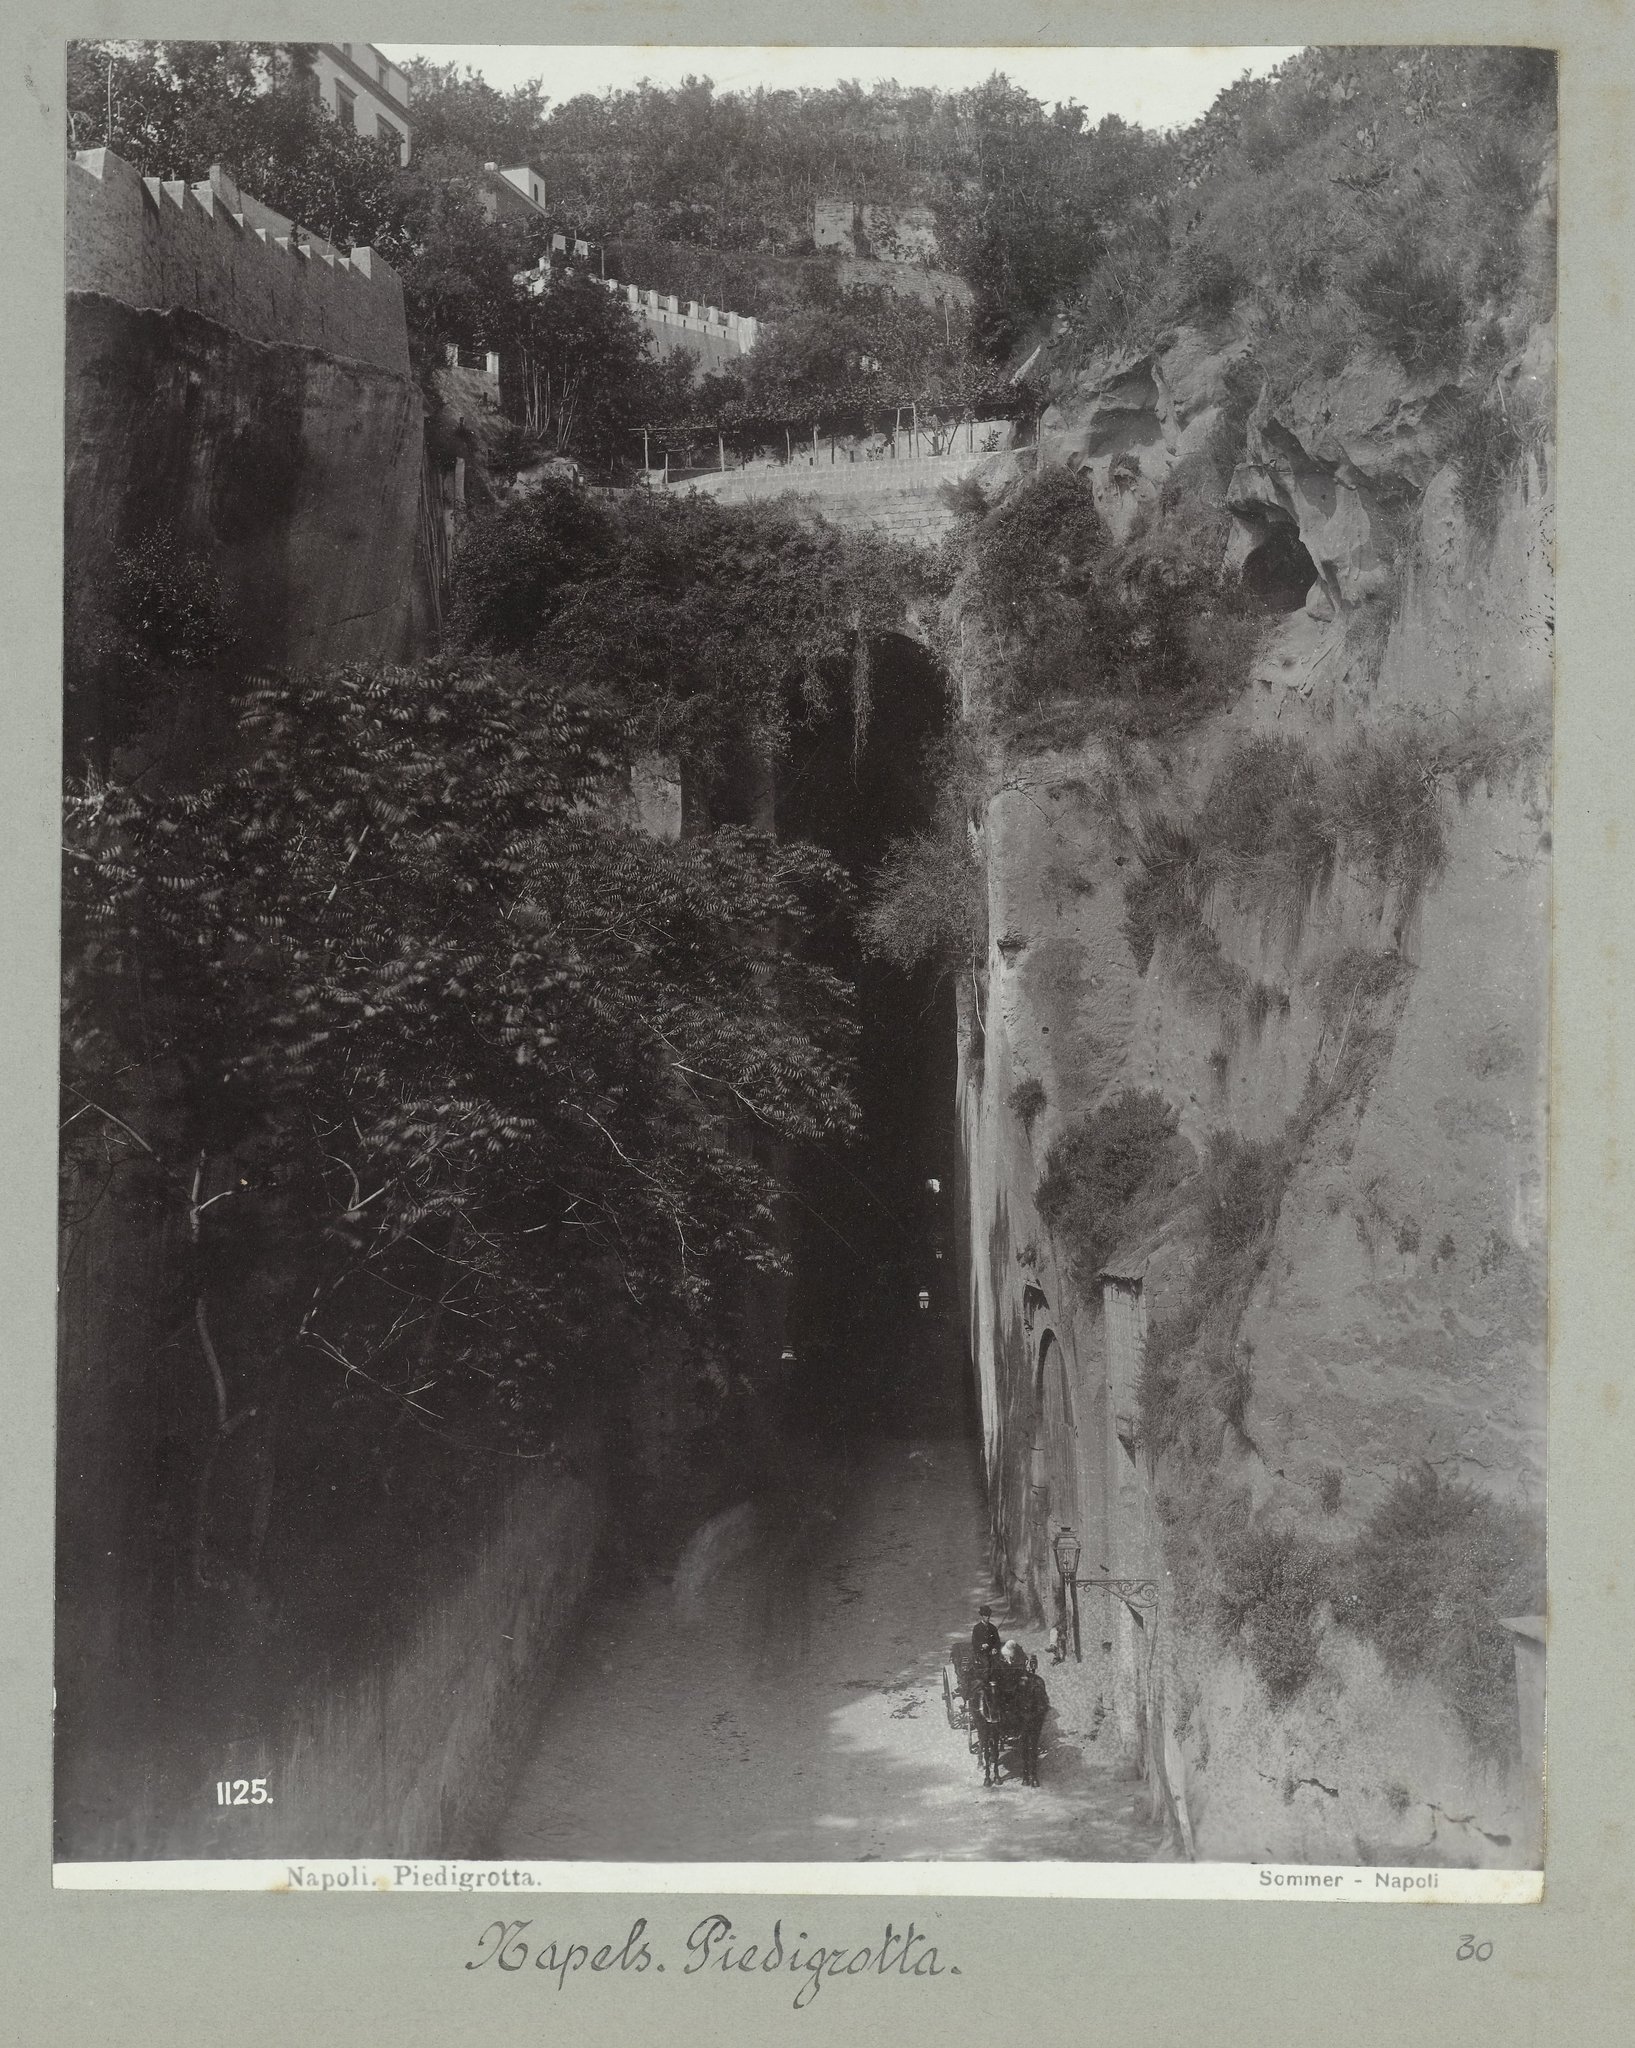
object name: photograph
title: Napels Piedigrotta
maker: giorgio sommer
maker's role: fotograaf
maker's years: 1834-1914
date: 1893-1903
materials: cardboard, photographic support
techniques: albumen print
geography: netherlands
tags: italy